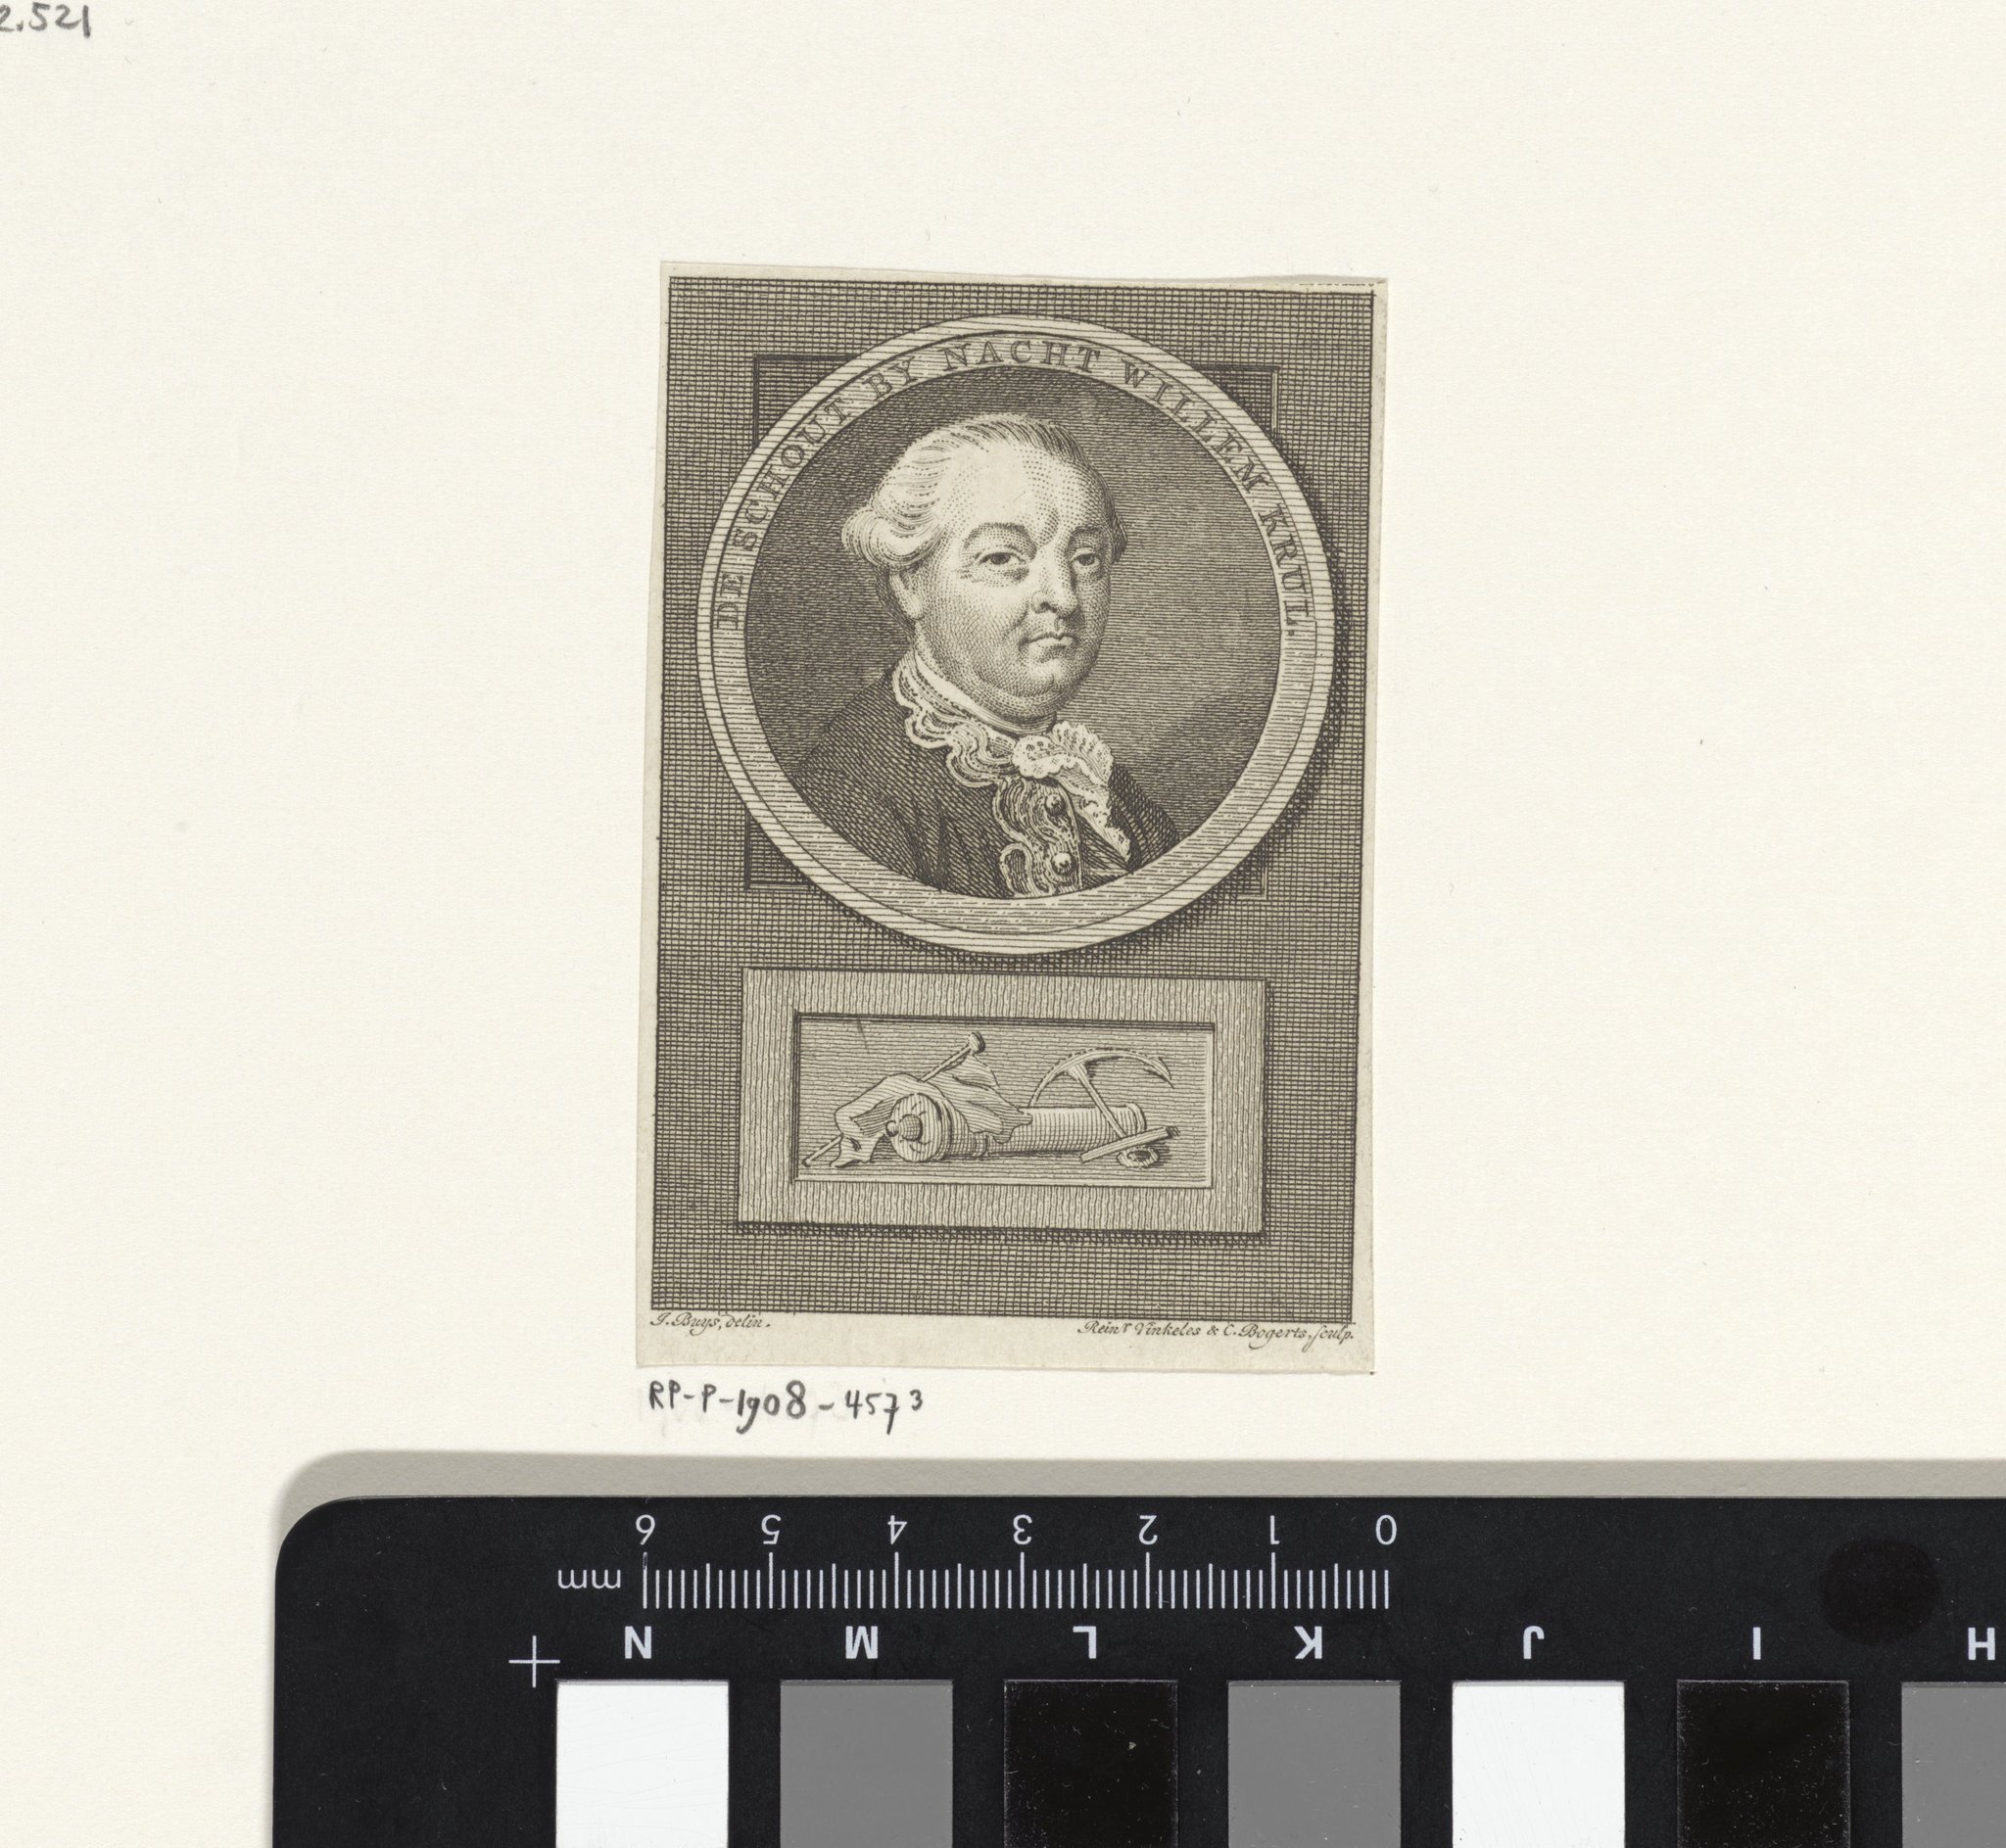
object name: book illustration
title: Portret van Willem Crul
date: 1783-1795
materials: paper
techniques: engraving, etching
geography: amsterdam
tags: haarlem, firearms: cannon, parts of ship's exterior: anchor, (military) flags and standards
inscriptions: collector's mark: Lugt 2228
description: Prent gebruikt in: Fokke, Jan. Geschiedenissen der Vereenigde Nederlanden voor de vaderlandsche jeugd Ie-XXVste deel. Amsterdam: Johannes Allart, 1783-1795. Deel XIV.